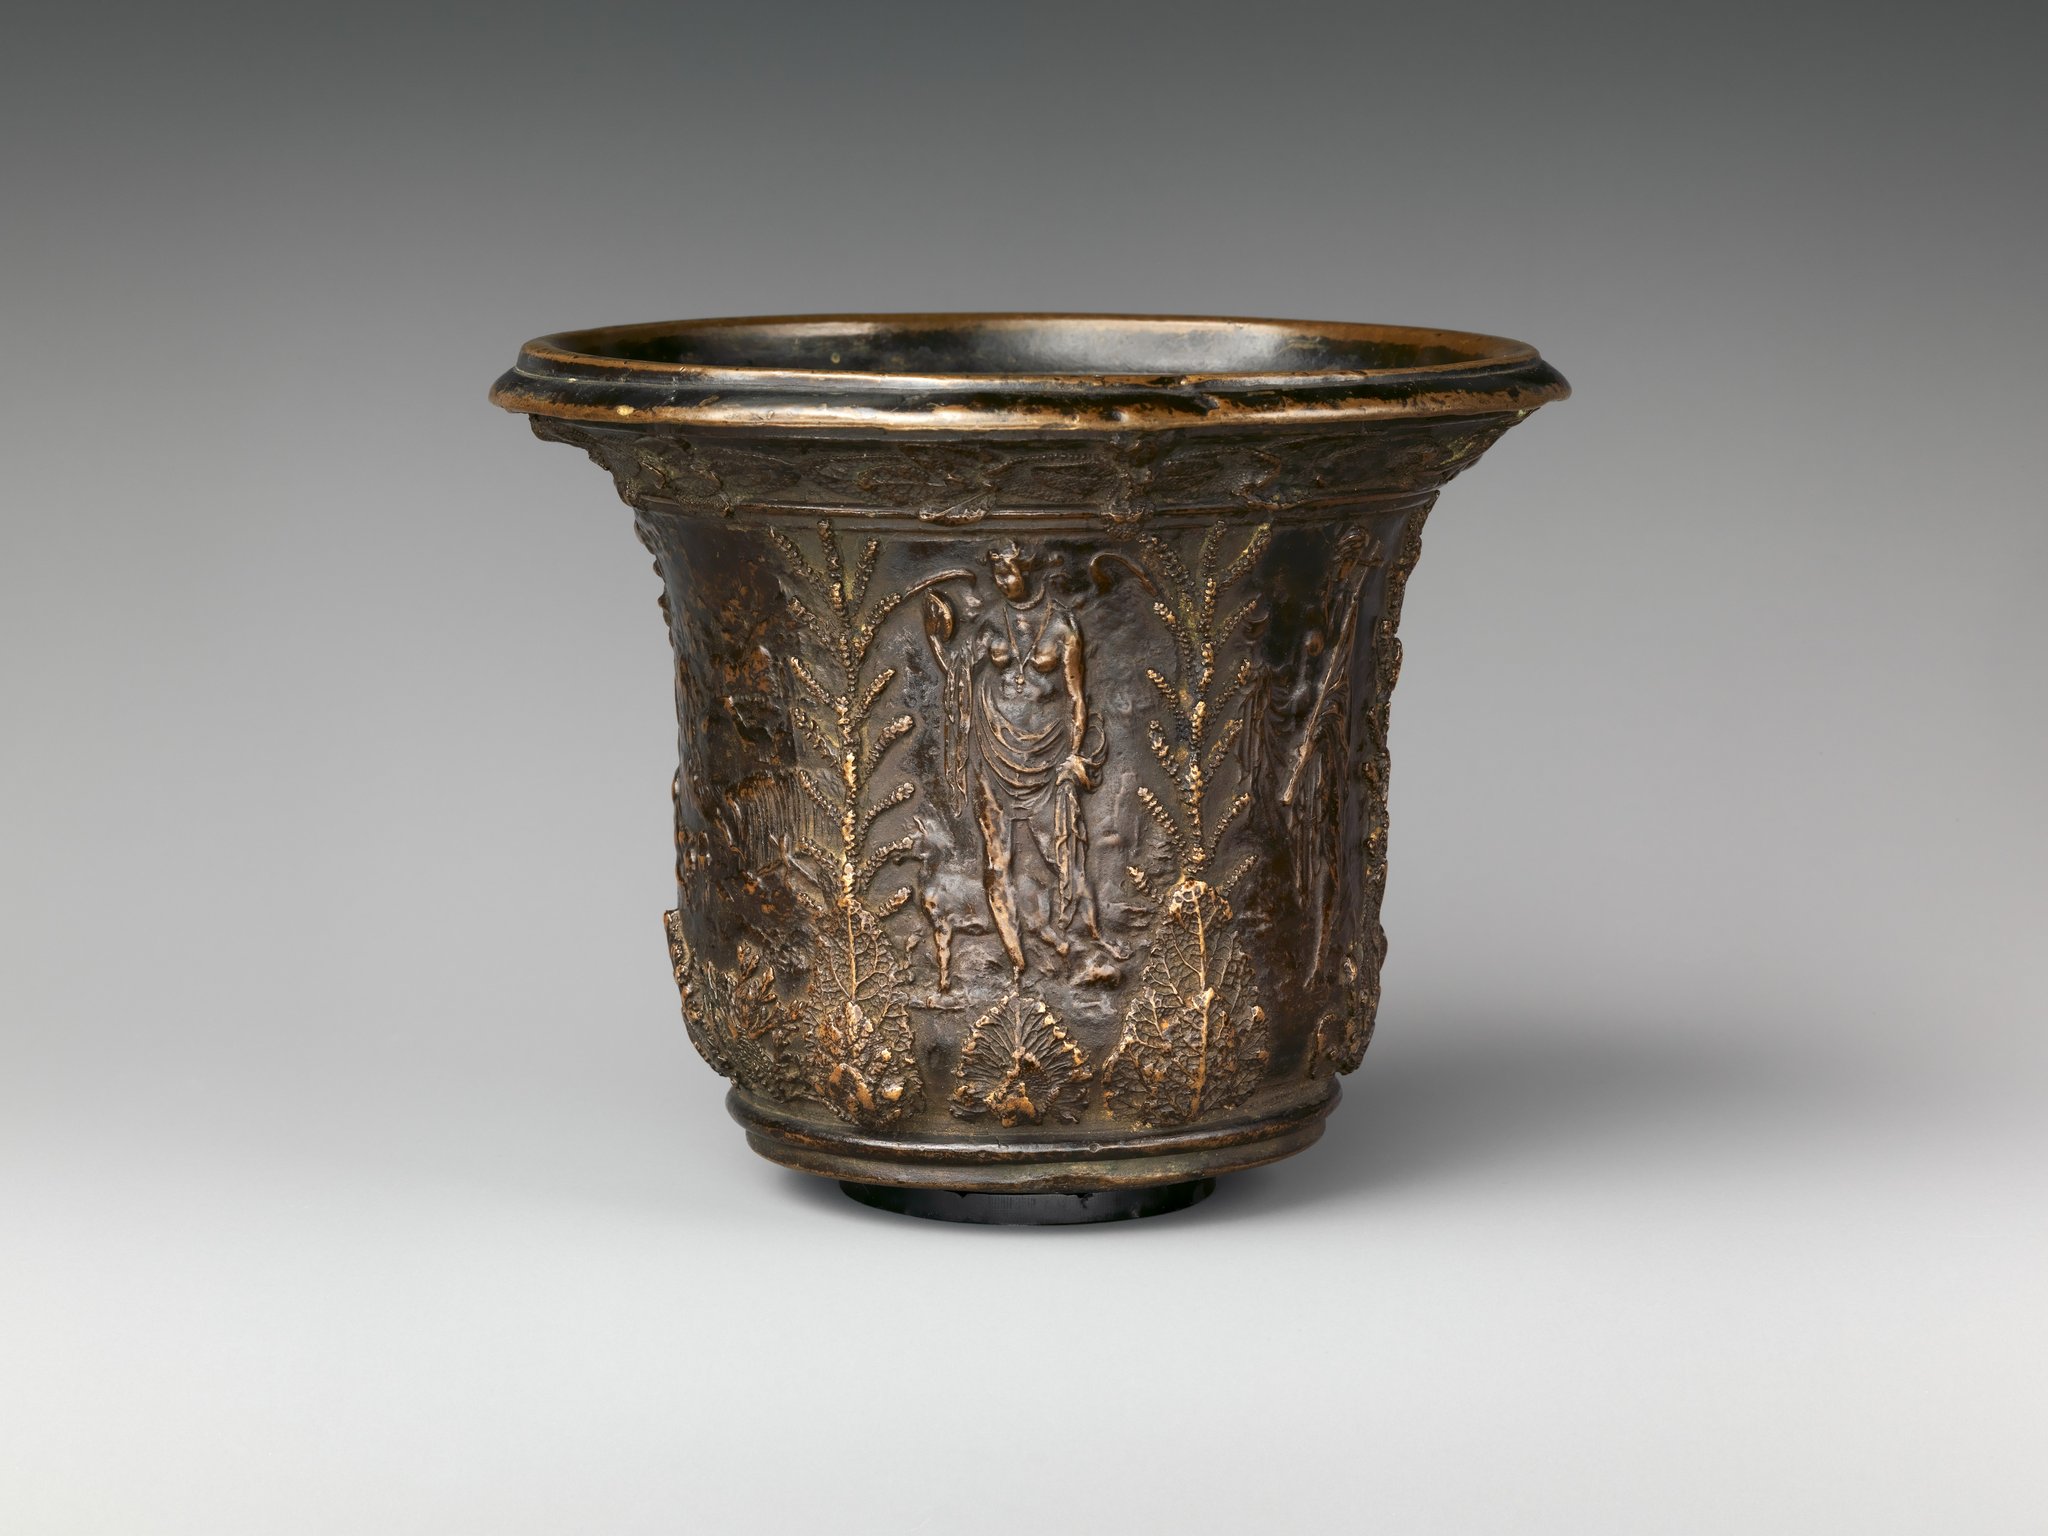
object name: mortar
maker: wenzel jamnitzer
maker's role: maker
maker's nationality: german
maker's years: 1507-1585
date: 1550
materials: bronze